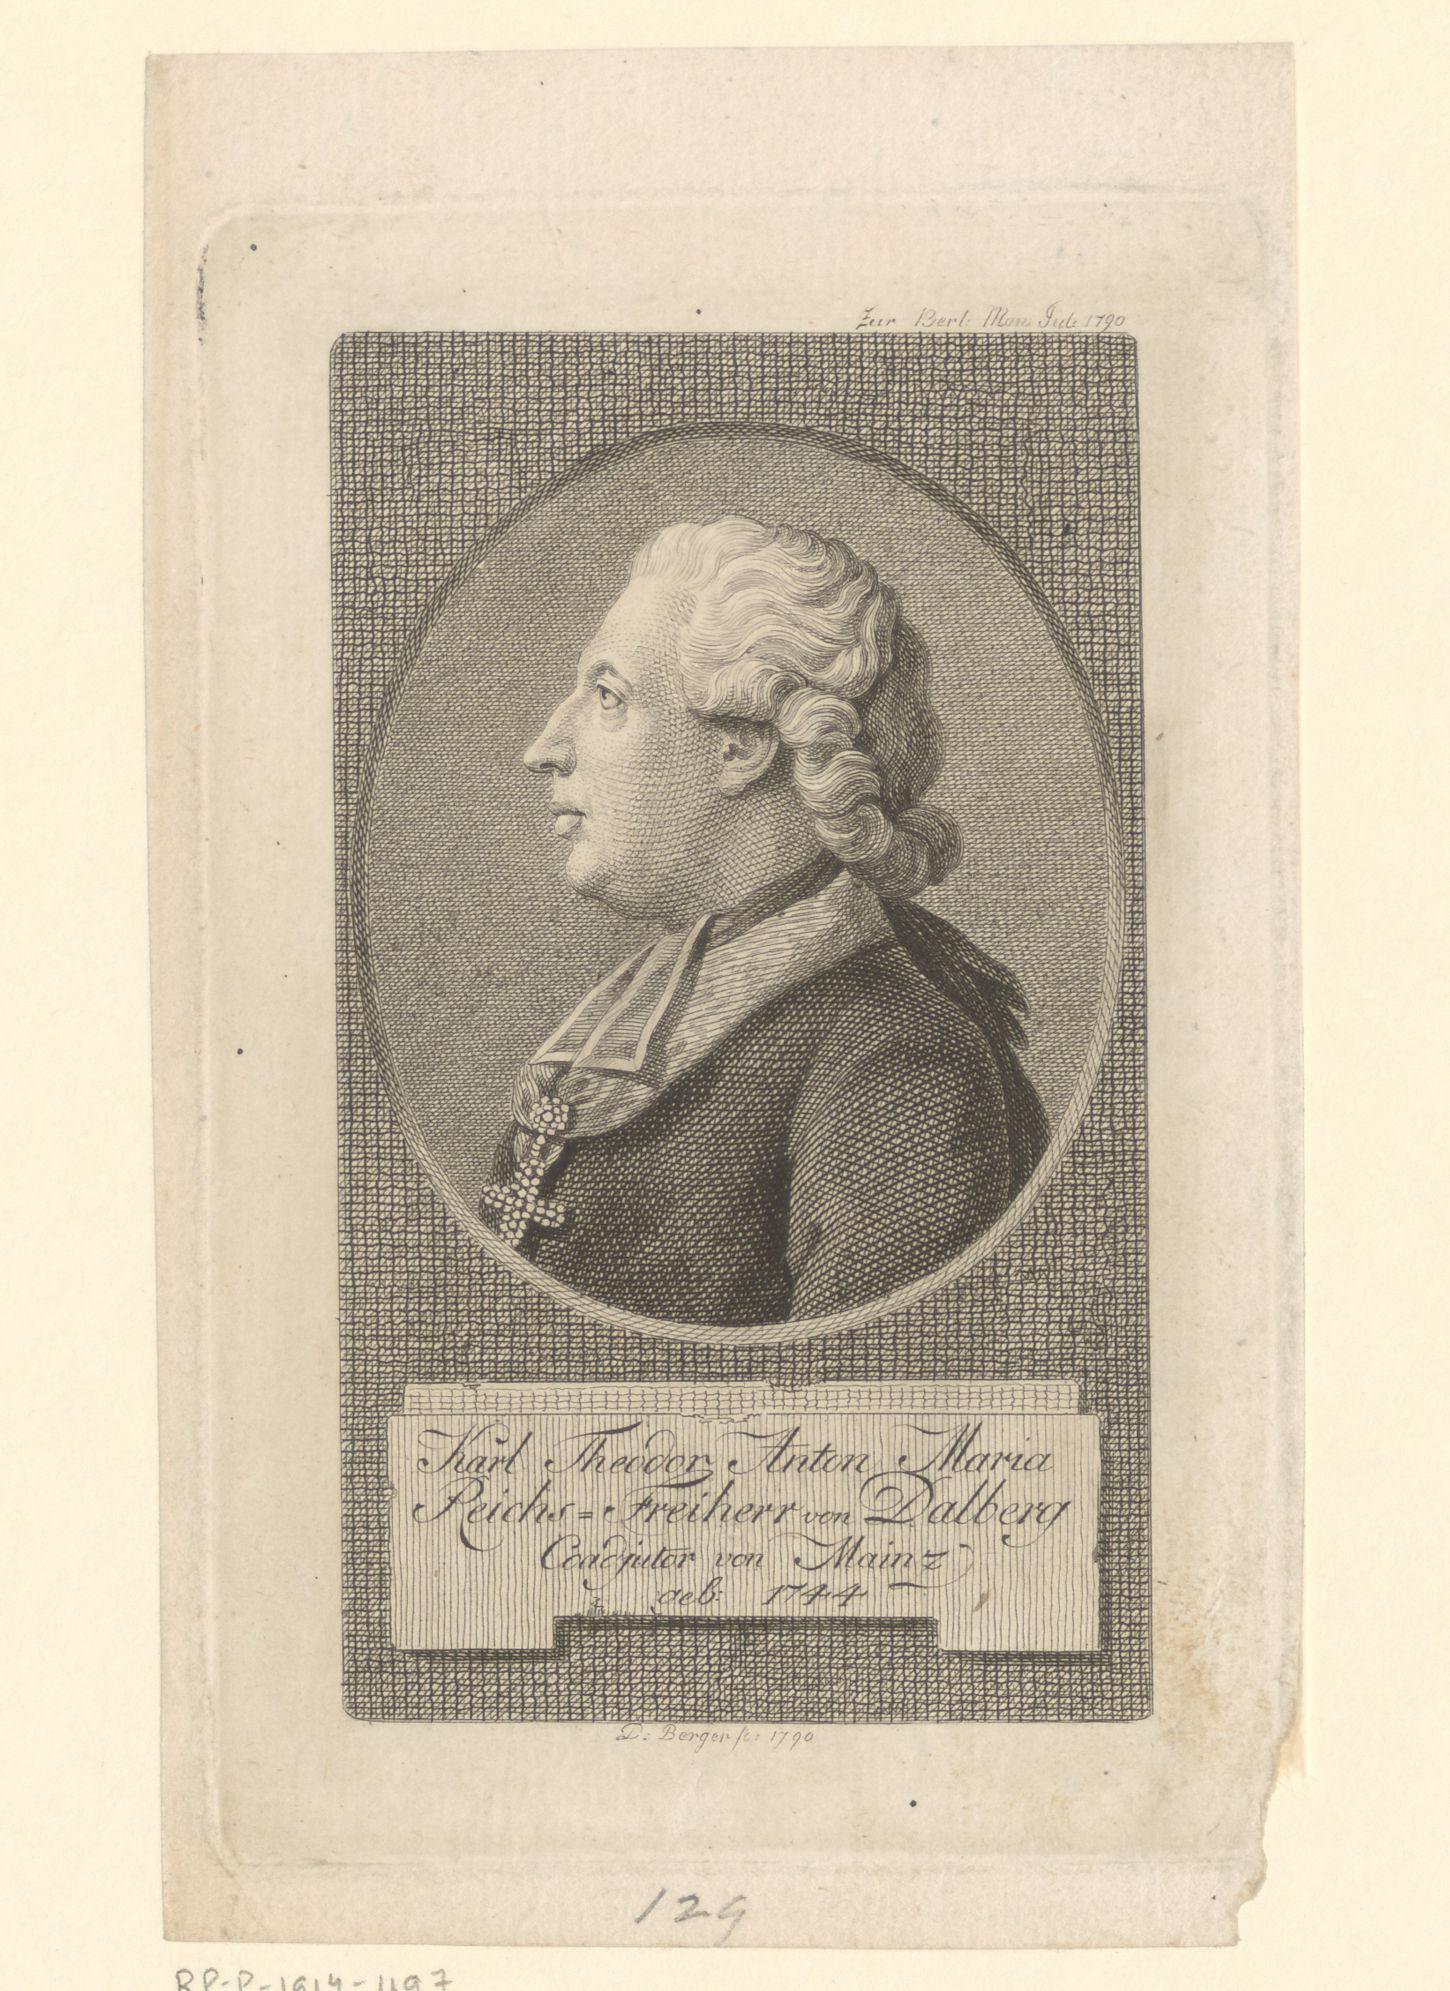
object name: print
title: Portret van Carl Theodor Anton Maria von Dalberg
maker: daniel berger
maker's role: print maker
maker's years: 1744-1824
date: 1790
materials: paper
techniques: engraving, etching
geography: berlin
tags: priest, karl theodor von dalberg, historical persons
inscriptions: collector's mark: Lugt 2228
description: Prent afkomstig uit: Berlinischen Monatschrift. Berlijn: Haude und Spener, 1790.